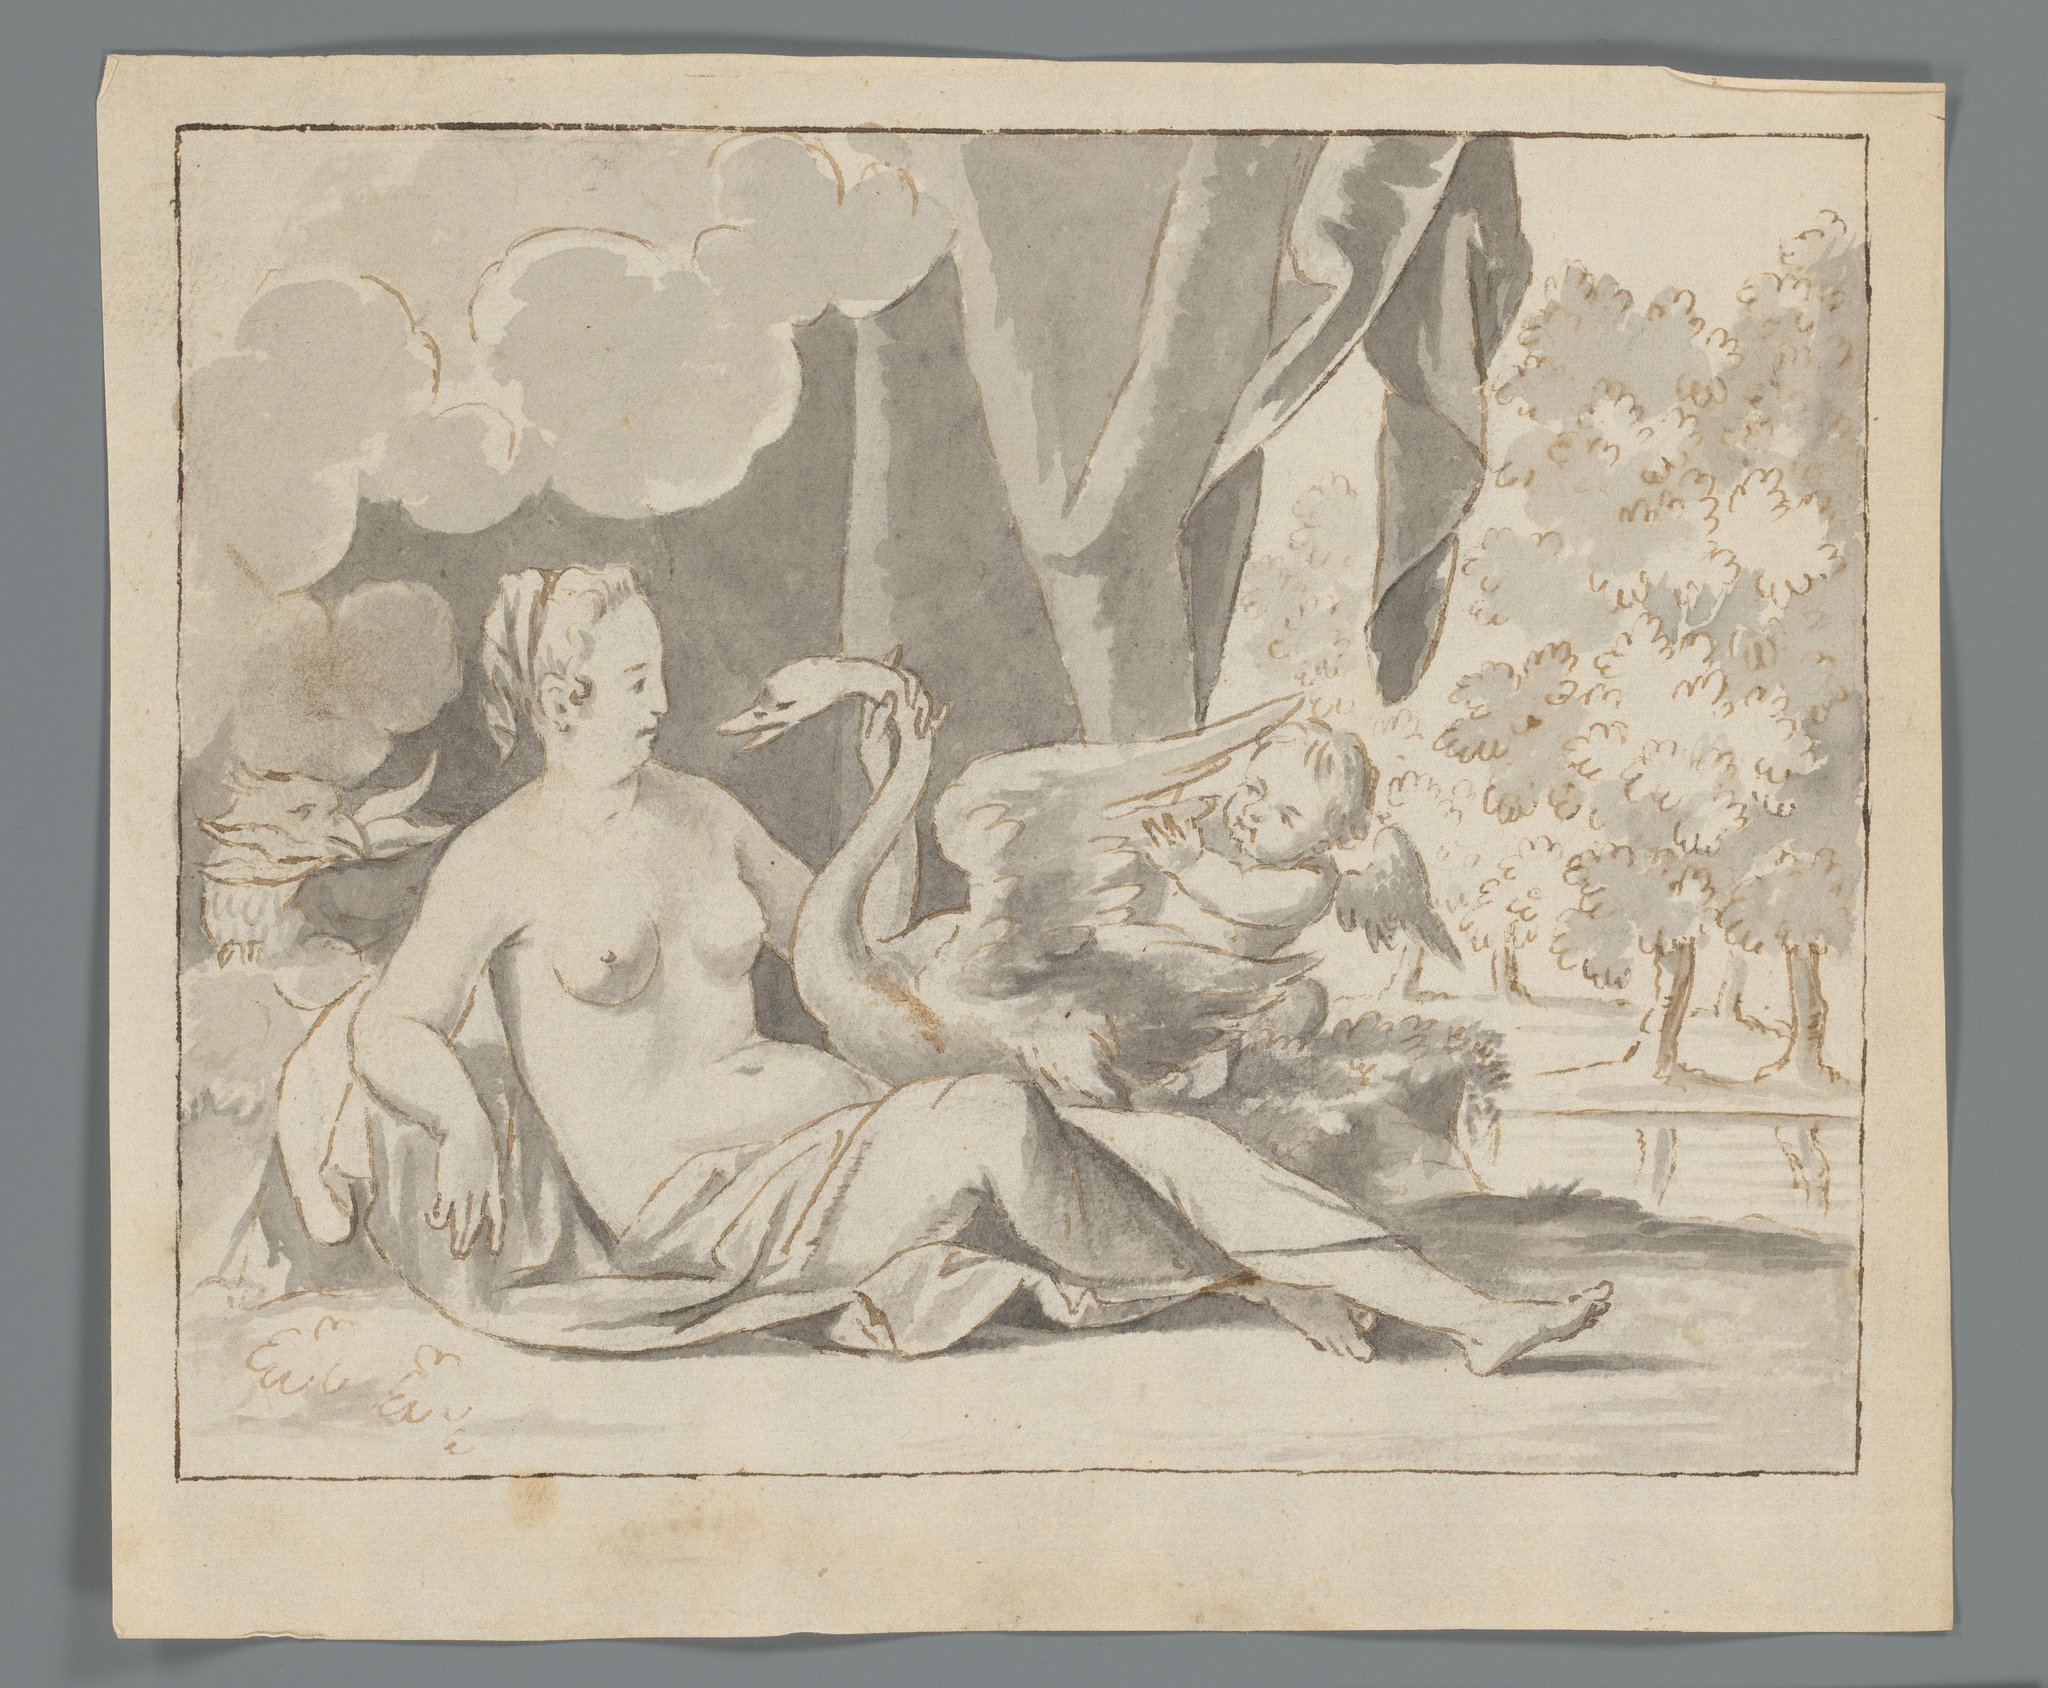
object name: drawing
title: Leda en de zwaan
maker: matthijs balen (1684-1766)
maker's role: draughtsman, painter, print maker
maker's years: 1684-1766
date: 1694-1766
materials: paper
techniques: brush, pen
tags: jupiter, in the shape of a swan, and leda